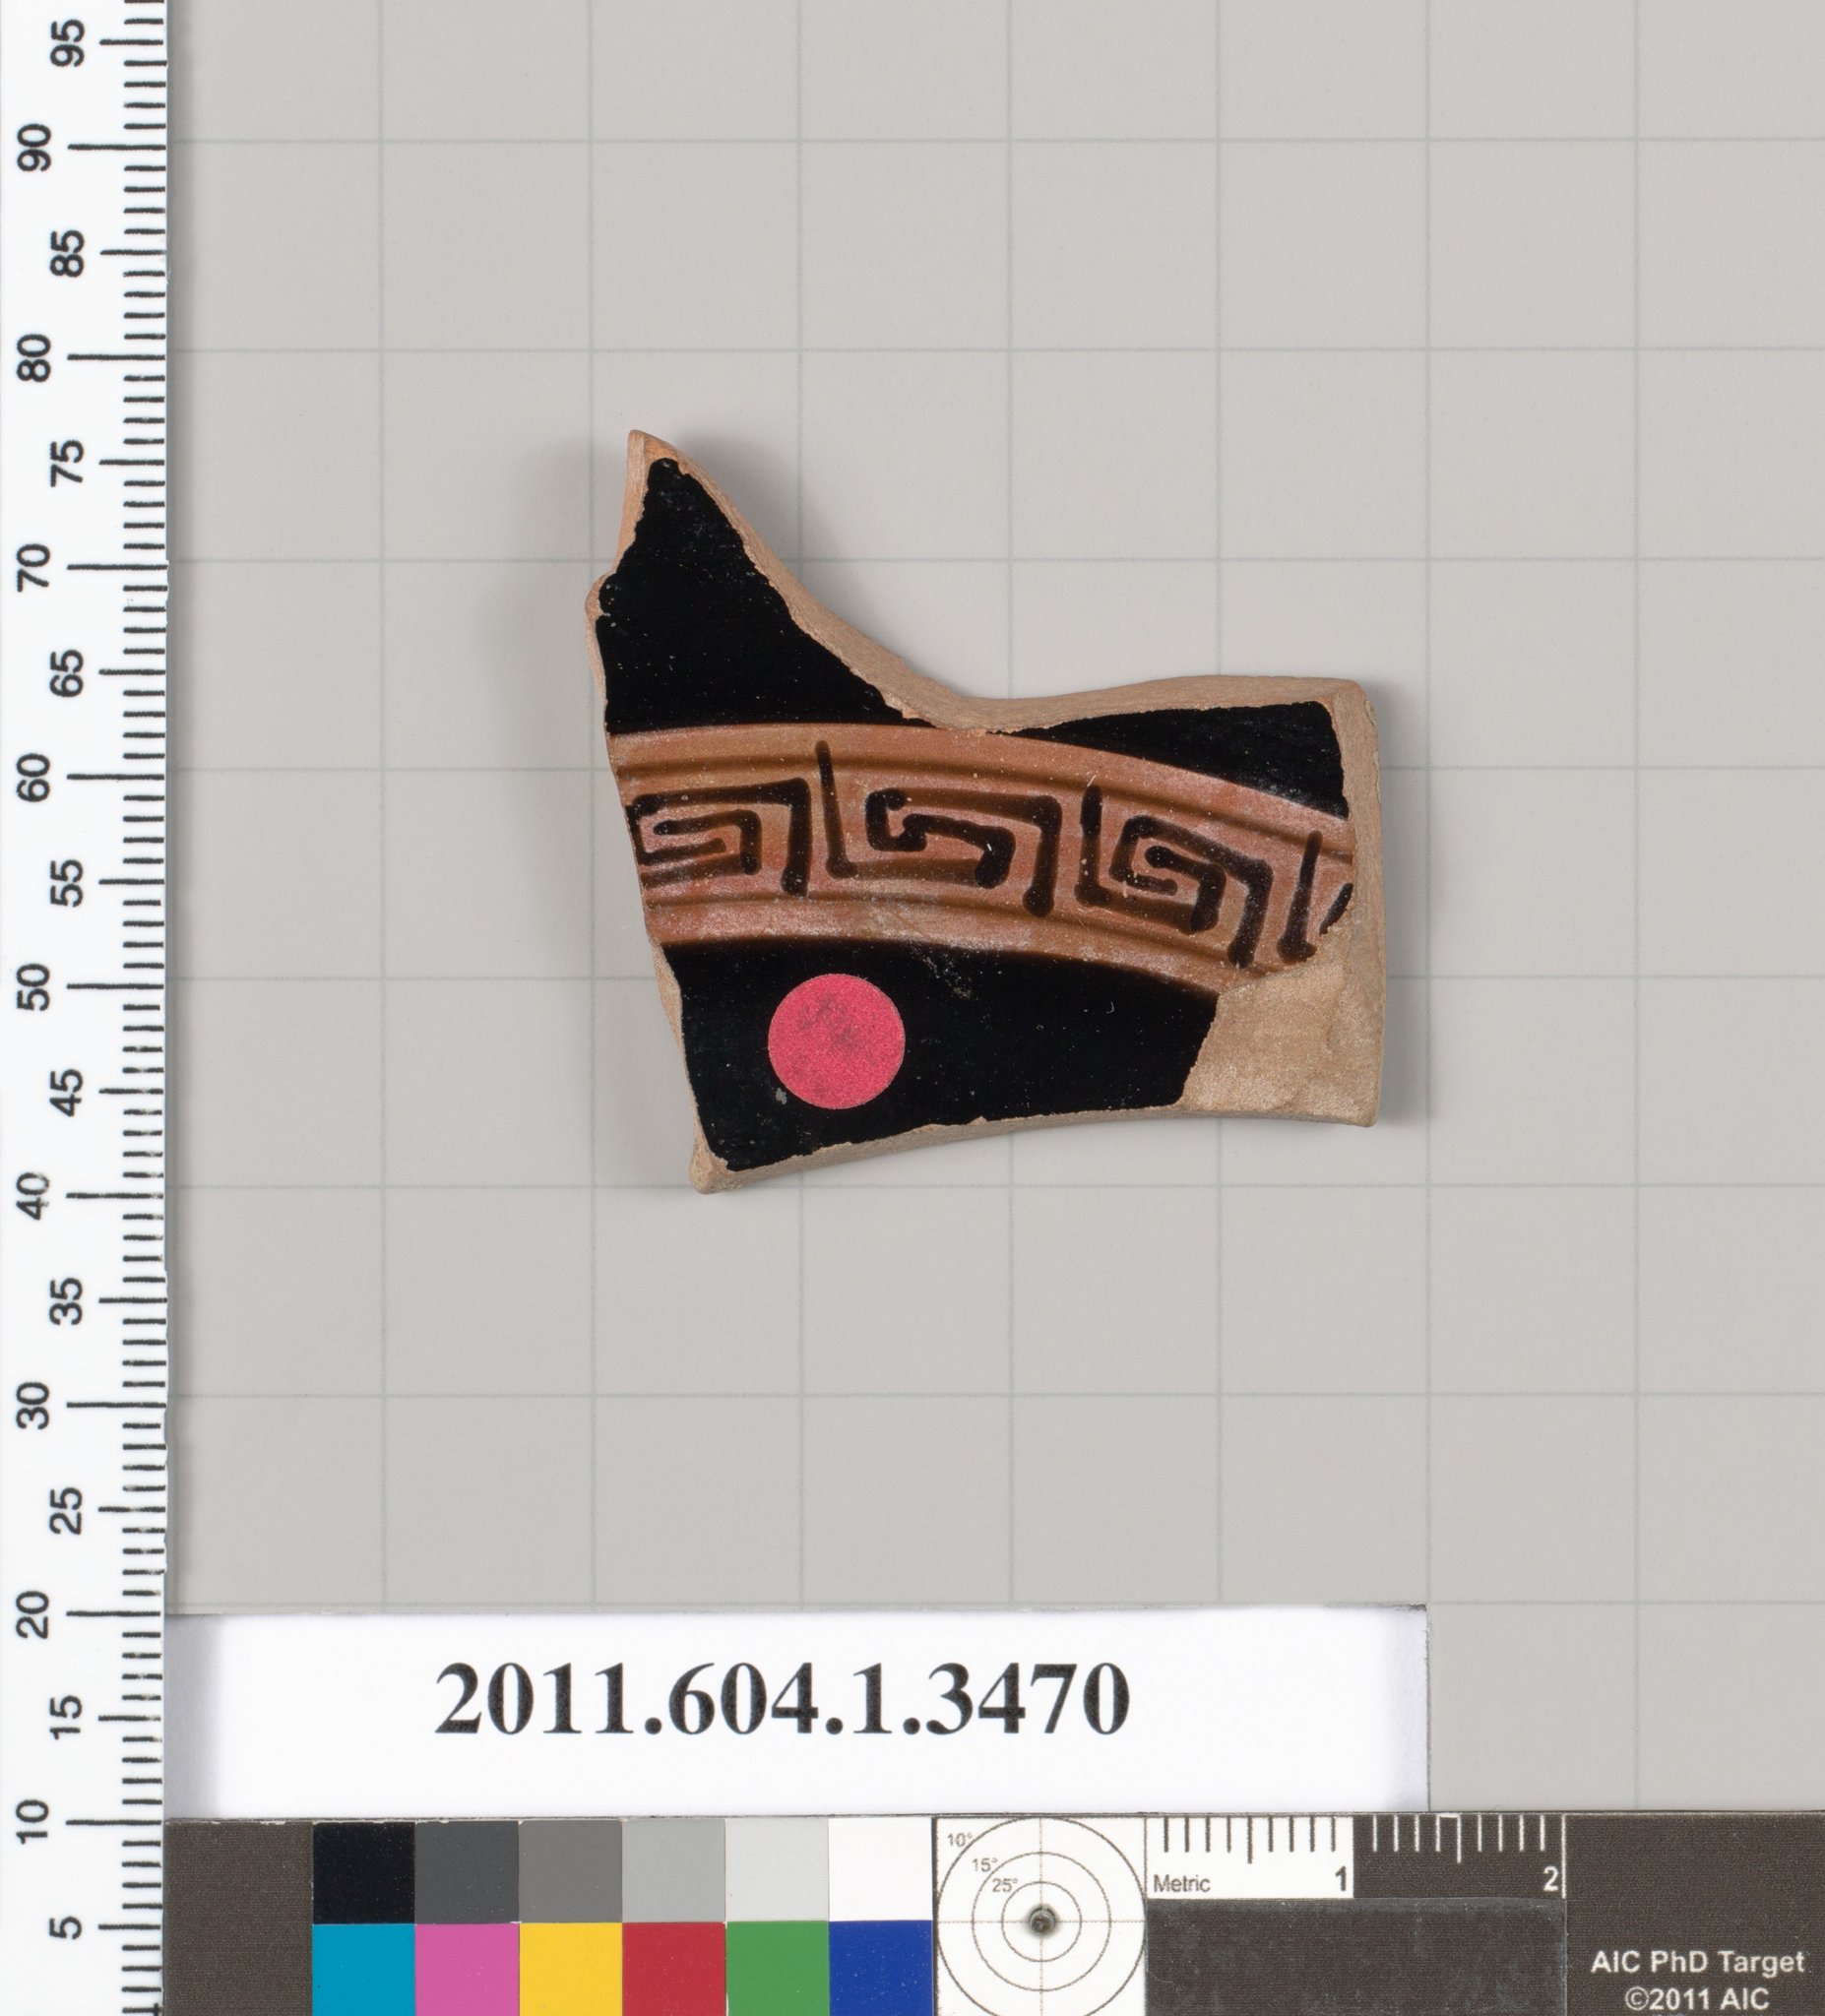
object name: kylix fragment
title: Terracotta fragment of a kylix (drinking cup)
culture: greek, attic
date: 500-475 BCE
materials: terracotta